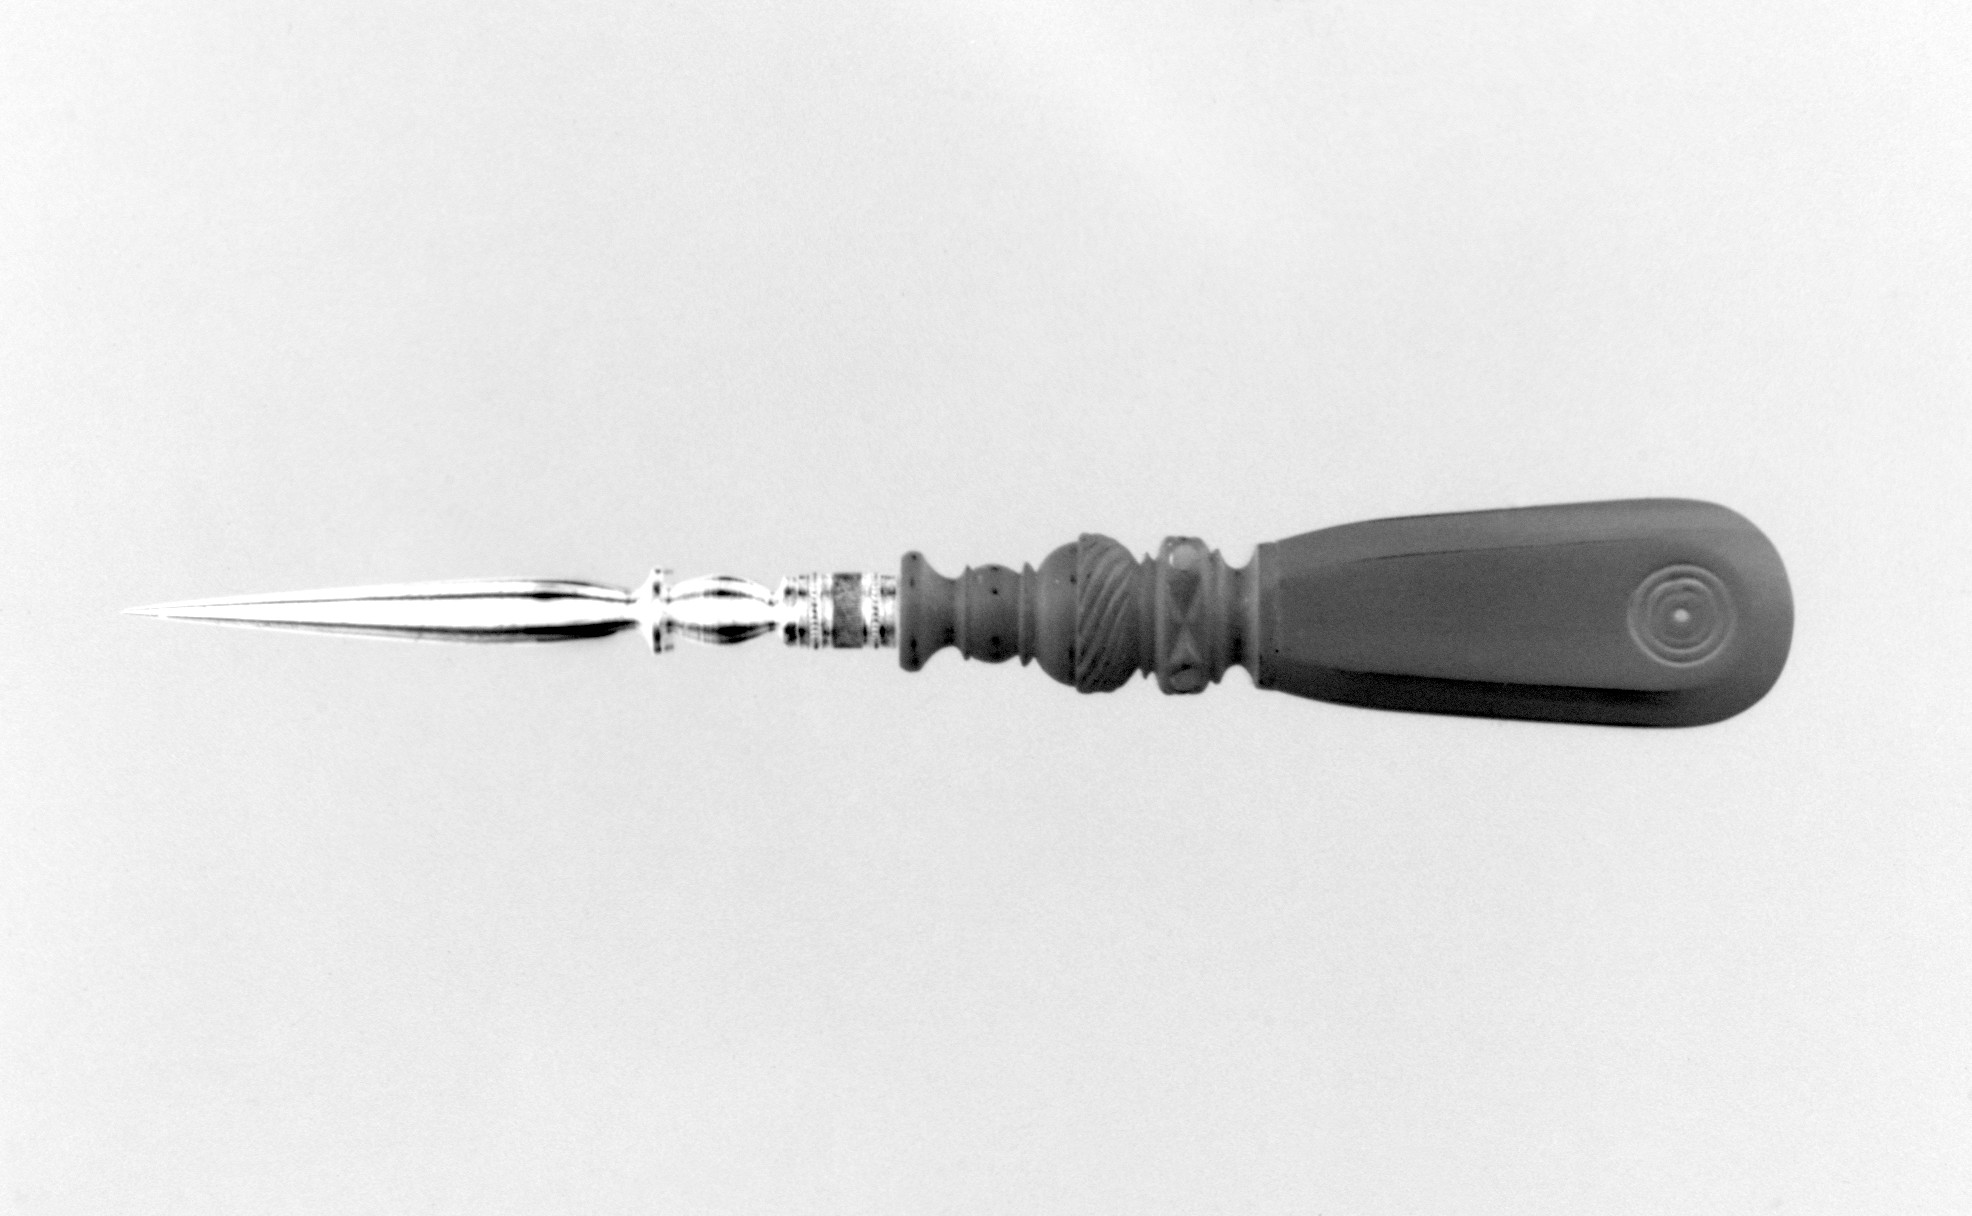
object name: stiletto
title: Stiletto (part of a set)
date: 1848-1849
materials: ivory, silver, steel